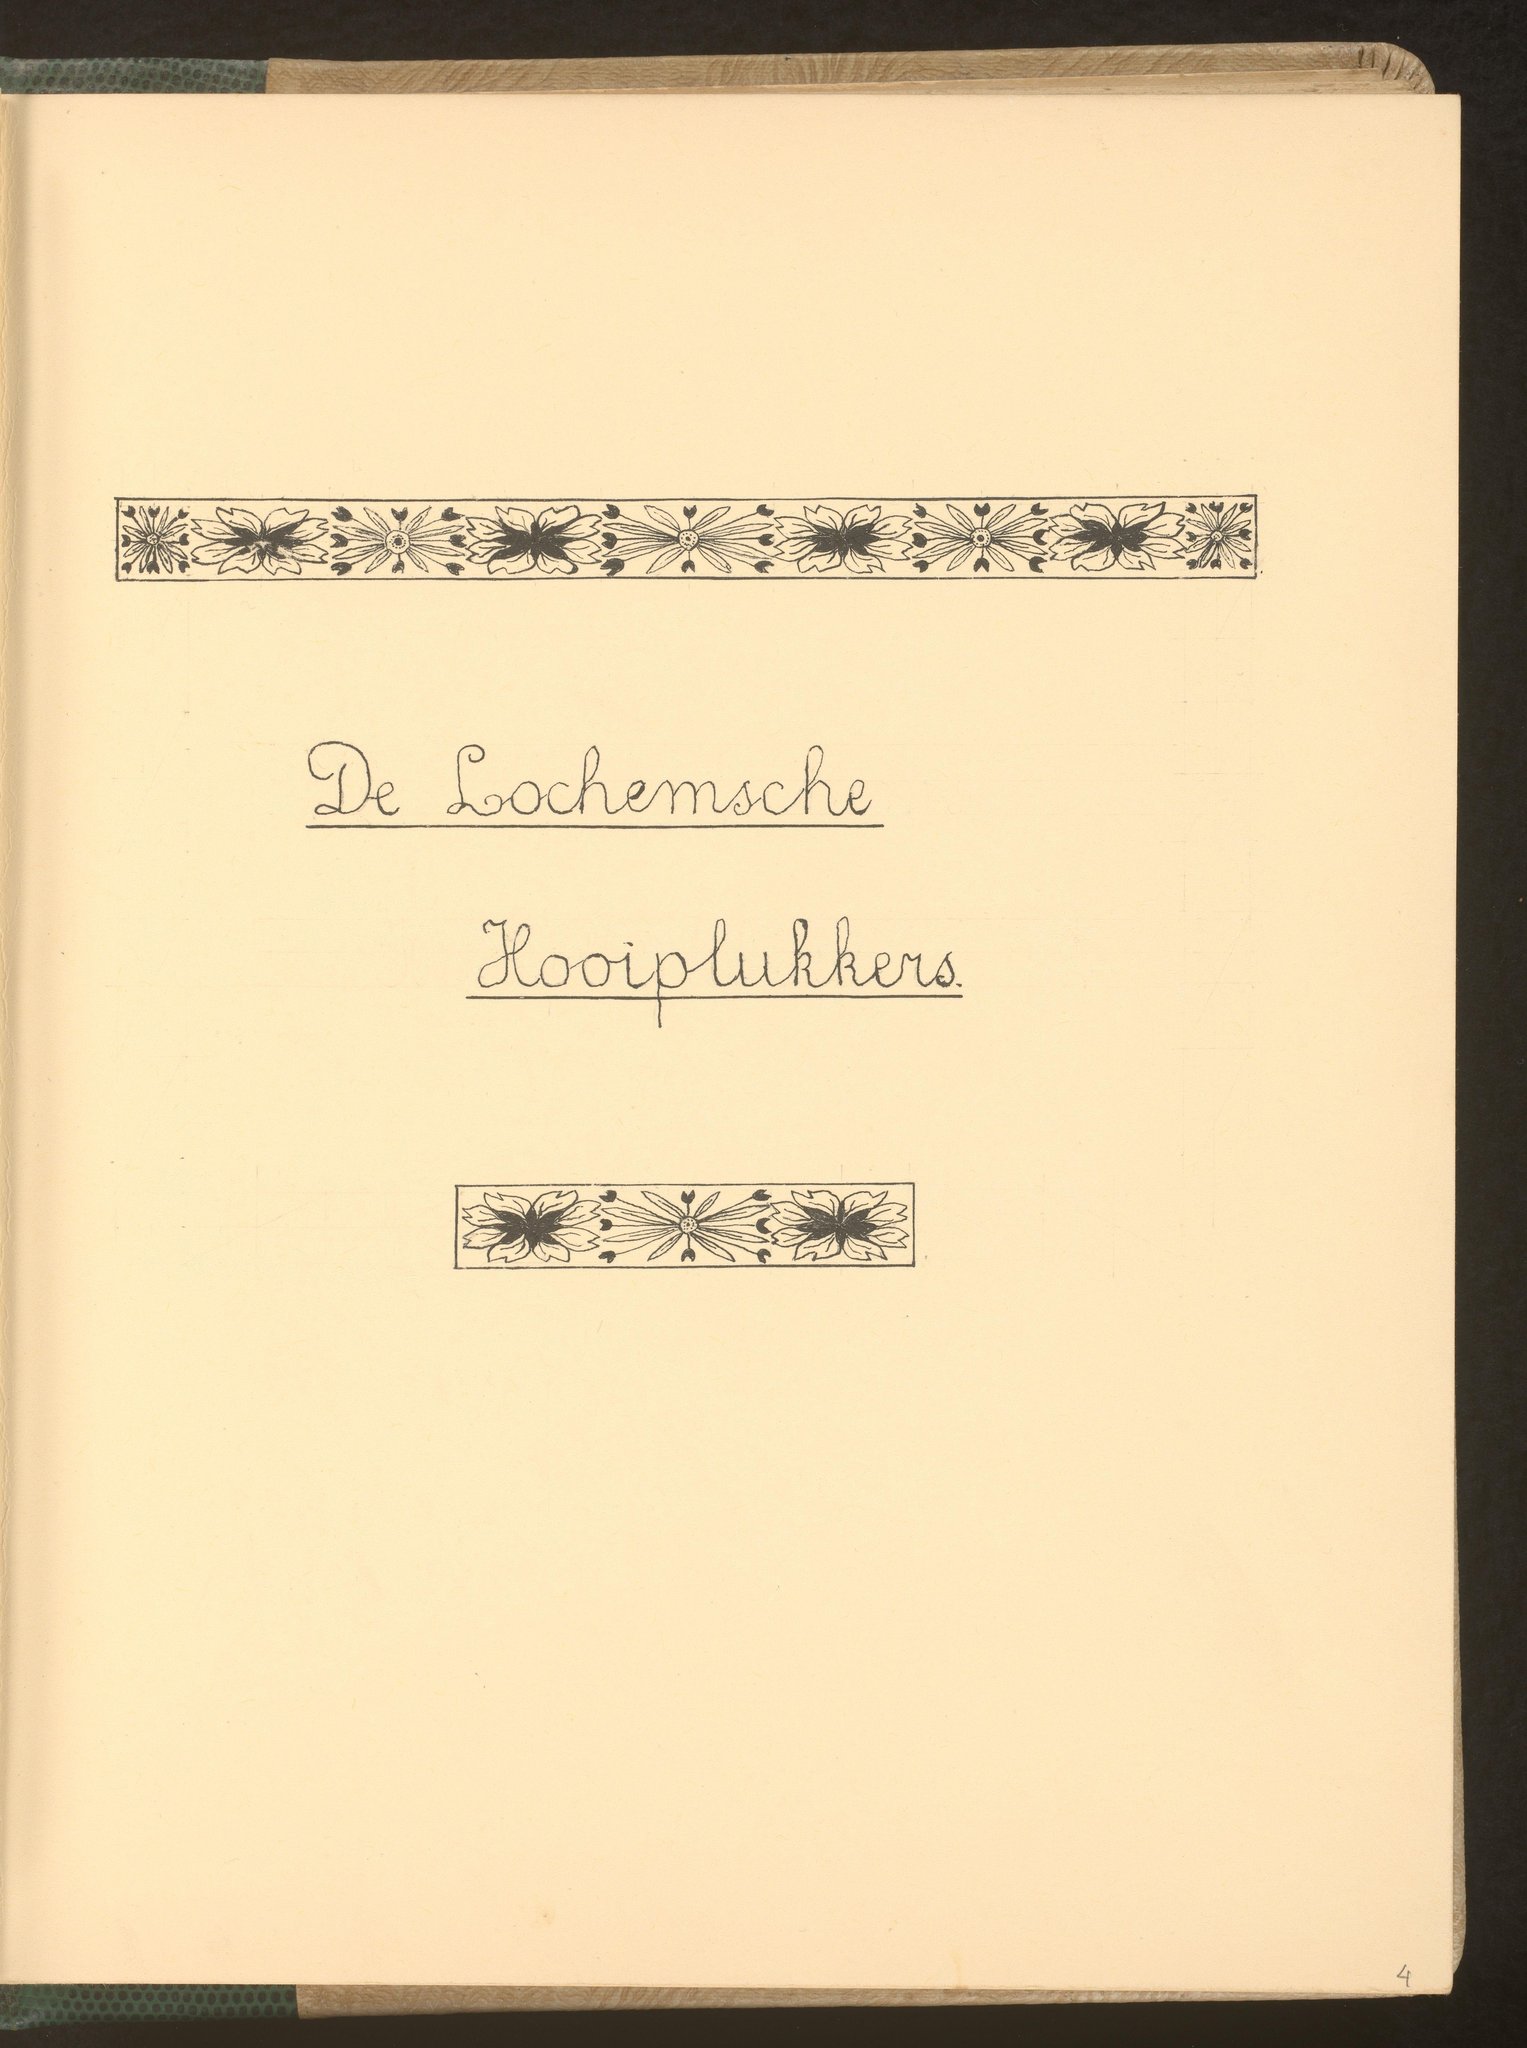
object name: manuscript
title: De Lochemse Hooiplukkers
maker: Anonymous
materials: ink, paper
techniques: handwriting, pen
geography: lochem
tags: willem drees, old-people's home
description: Handgeschreven titel voor de foto op het volgende blad. Onderdeel van het fotoalbum over de opening van het bejaardenhuis De Berkelhof in Lochem door premier Willem Drees op 8 augustus 1953.